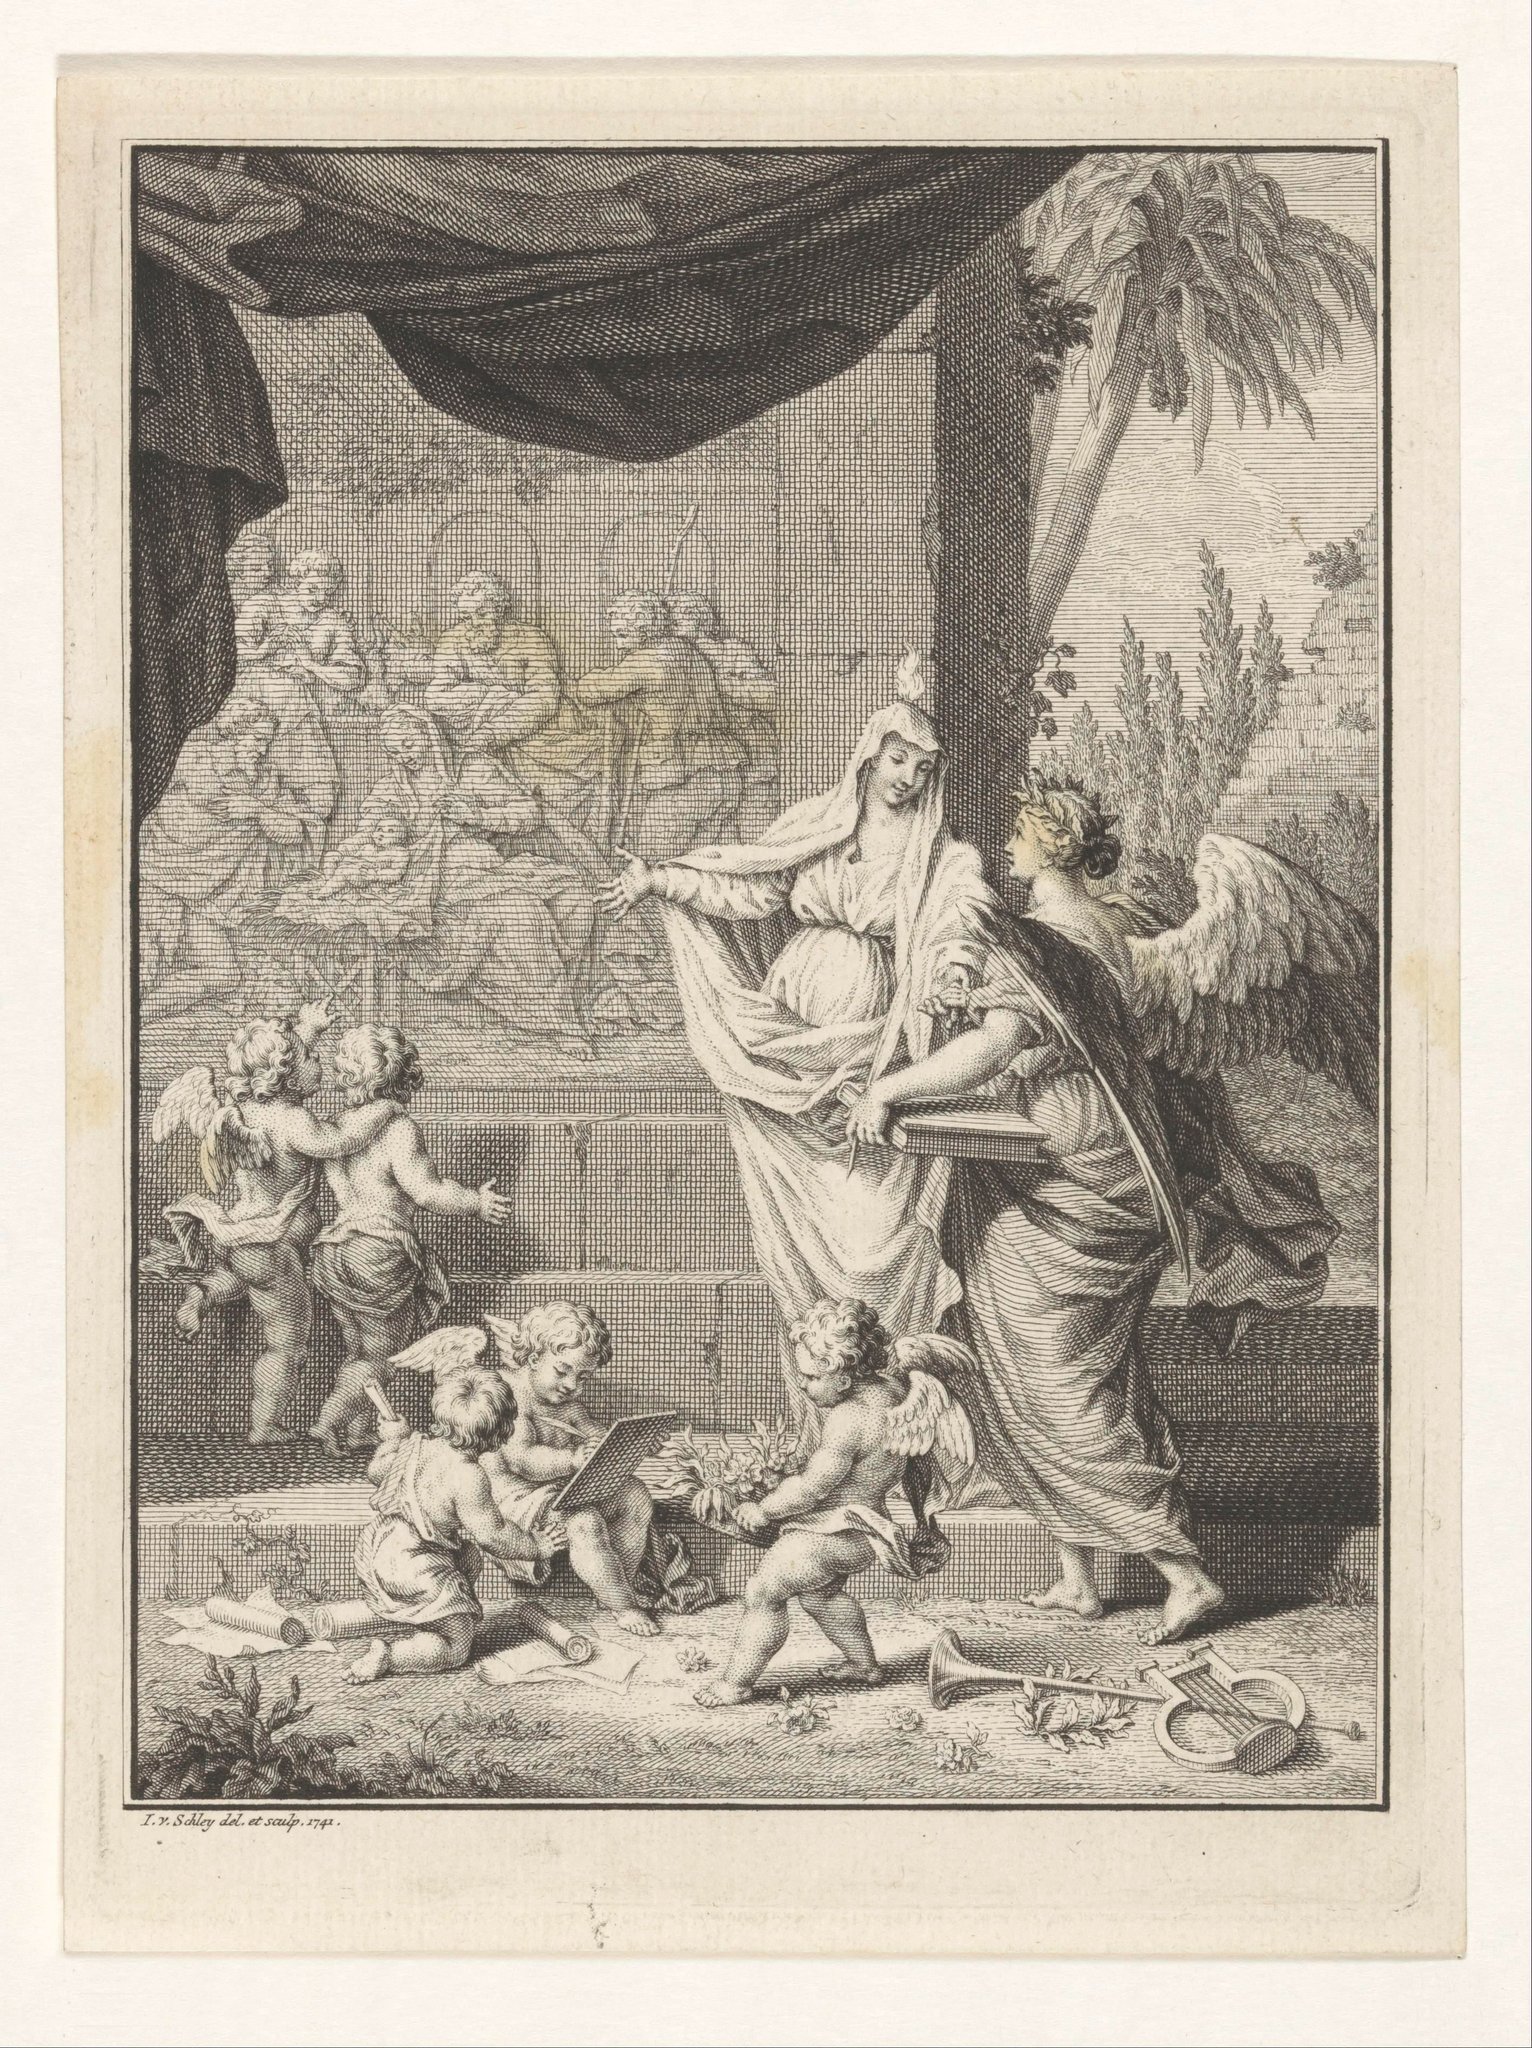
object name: print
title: Waarheid en Geloof voor een reliëf met de aanbidding door de herders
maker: jacob van der schley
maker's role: draughtsman, print maker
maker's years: 1715-1779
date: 1741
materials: paper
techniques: engraving, etching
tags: fides (faith) as roman personification, adoration of the christ-child by the shepherds; mary and joseph present, truth; 'verità' (ripa)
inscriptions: collector's mark: Lugt 2760, collector's mark: Lugt 2228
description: Voor een reliëf van de aanbidding door de herders staan personificaties Waarheid en Geloof en vijf putti. Op de voorgrond liggen een lier en een bazuin.